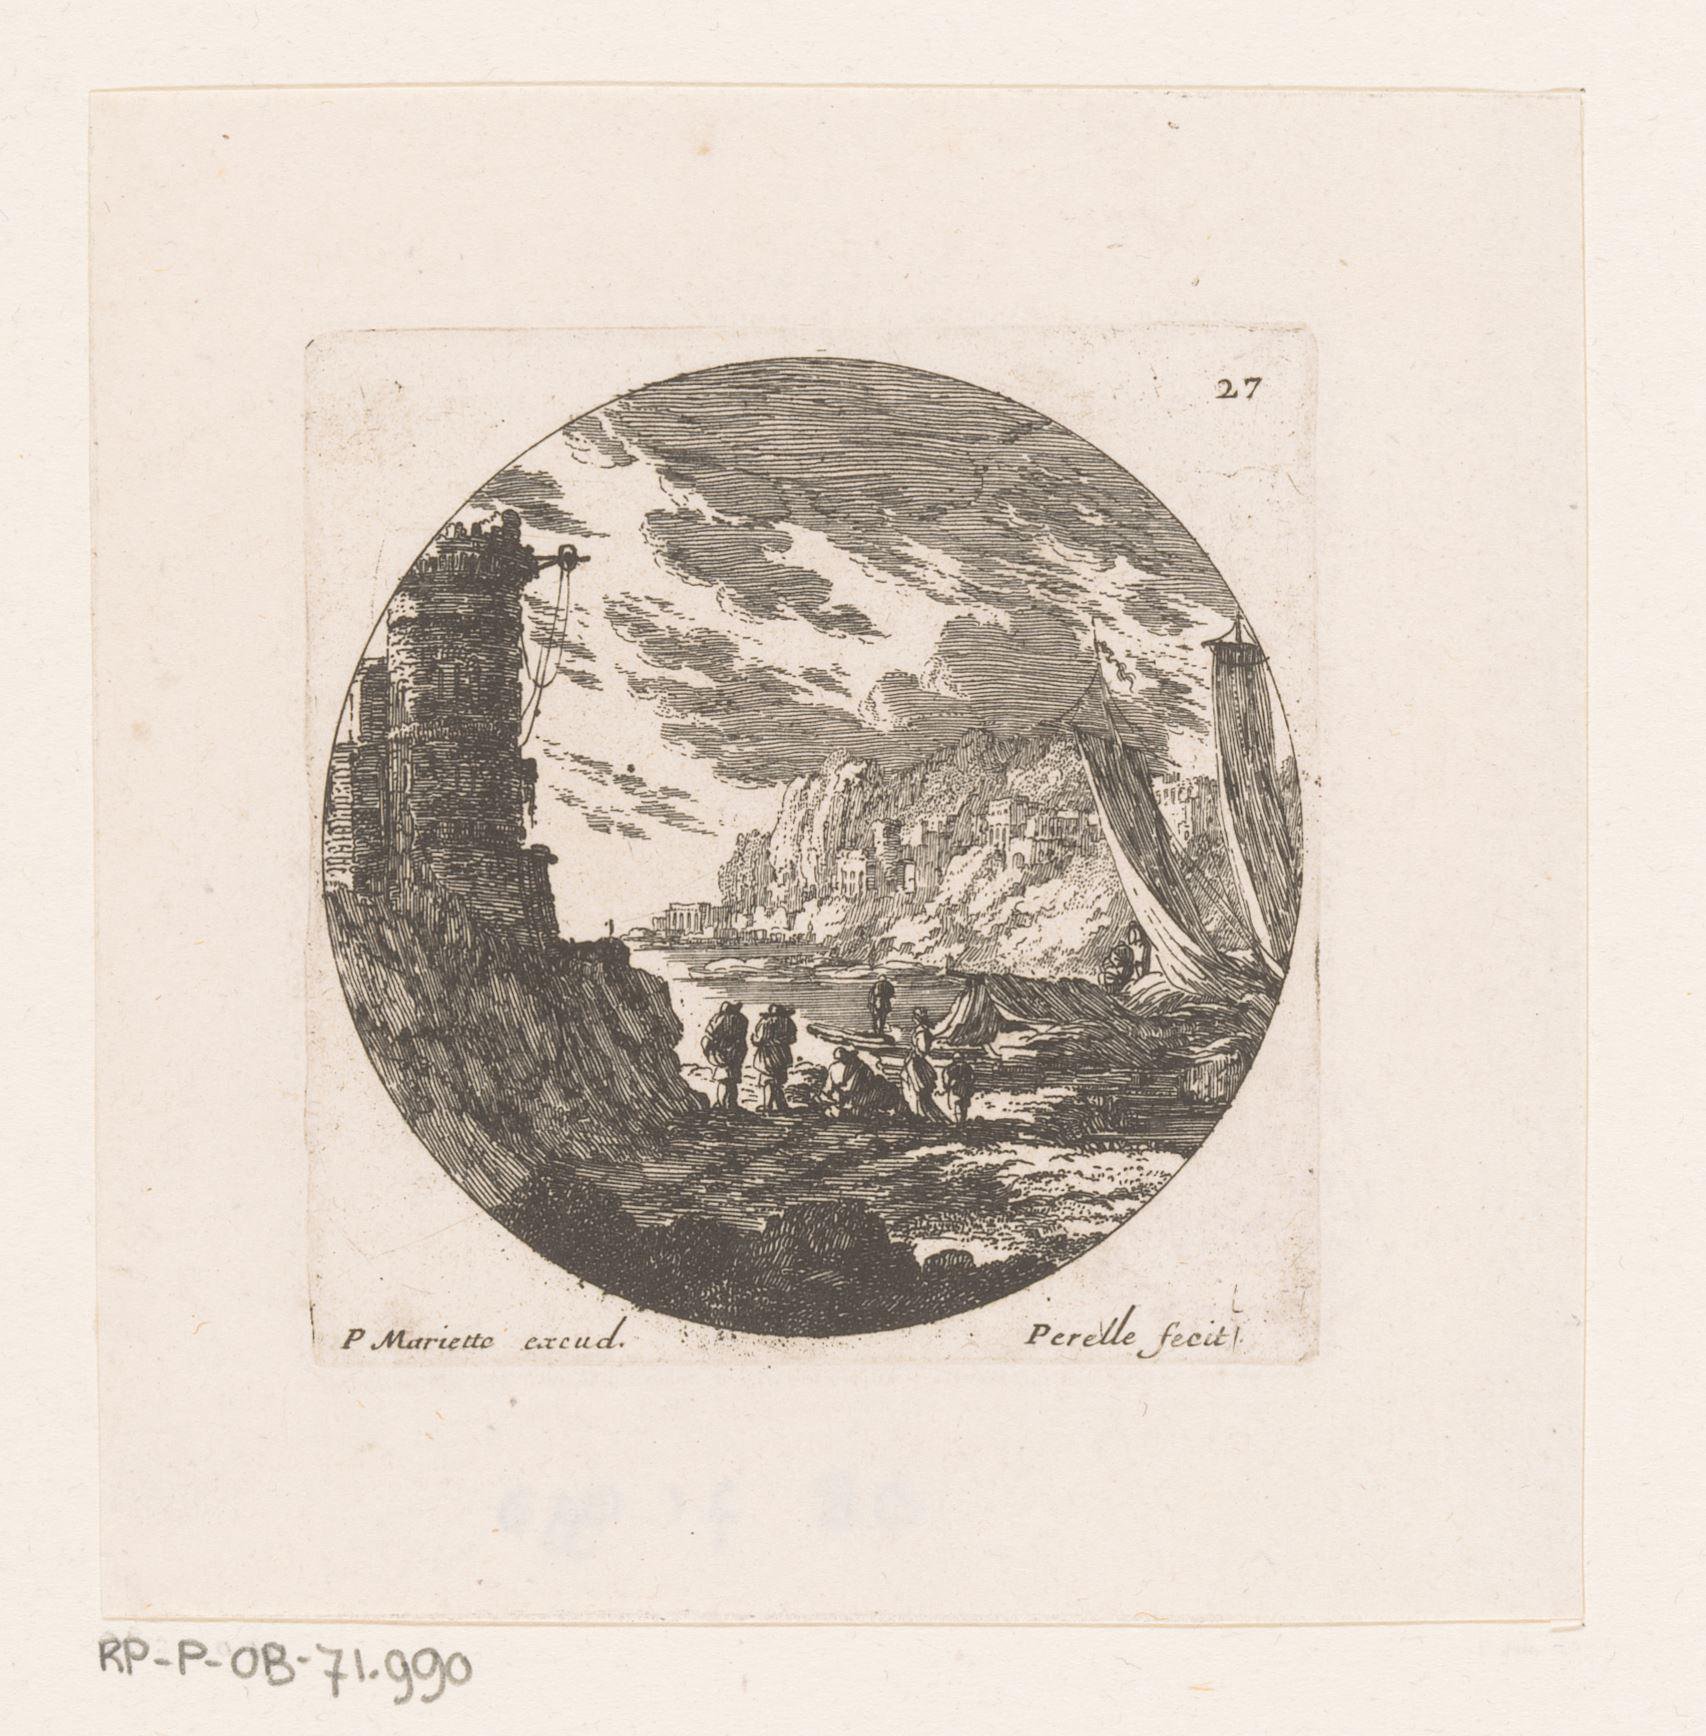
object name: print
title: Toren bij water met vrachtschepen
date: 1613-1695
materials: paper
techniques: etching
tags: landscape with tower or castle, water course (+ landscape with figures, staffage)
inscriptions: collector's mark: Lugt 240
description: Prenten met het signatuur 'Perelle' kunnen zowel door vader Gabriel als door zonen Nicolas en Adam gemaakt zijn.